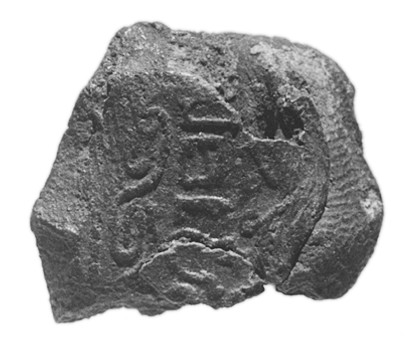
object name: sealing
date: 2030-1640 BCE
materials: clay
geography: egypt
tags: hieroglyphs